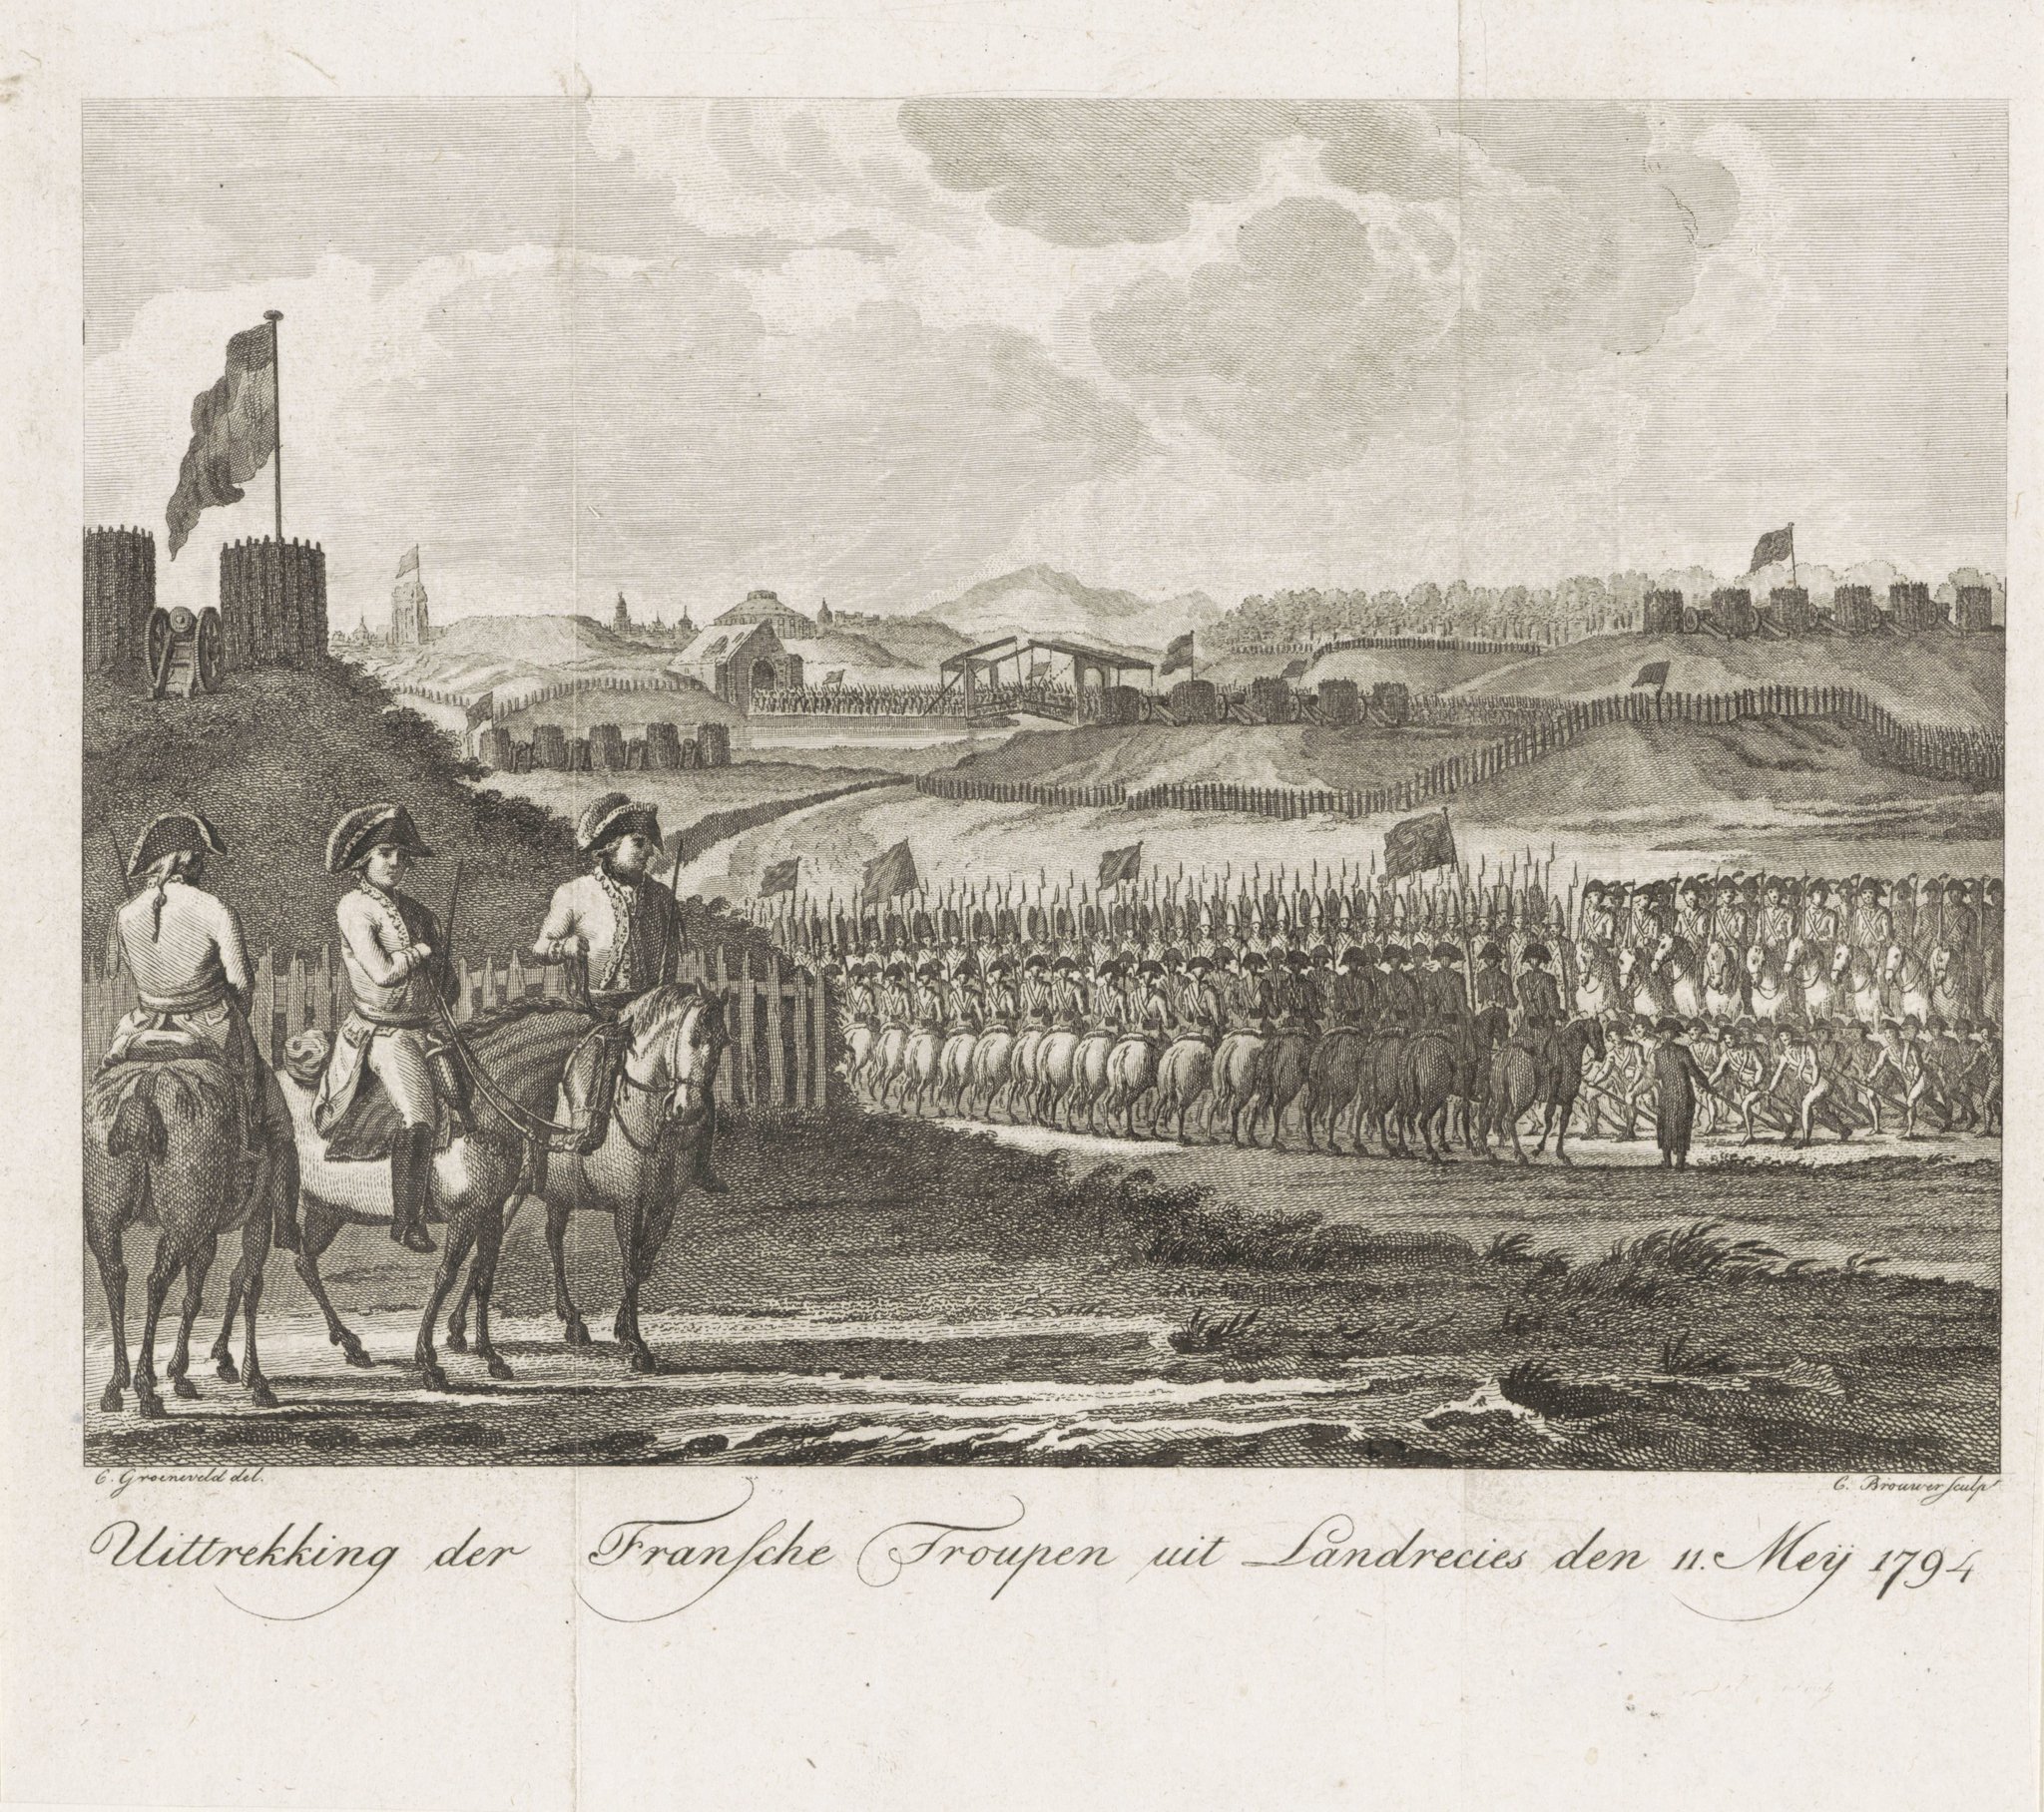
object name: history print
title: Franse troepen verlaten Landrecy, 1794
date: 1803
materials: paper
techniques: engraving, etching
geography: northern netherlands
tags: retreat of the defeated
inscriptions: collector's mark: Lugt 2228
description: Gebruikt als illustratie in: J.P. van Ginkel, Het leven van Willem George Fredrik, Prince van Orange. Rotterdam: J.P. van Ginkel, 1802-1803.